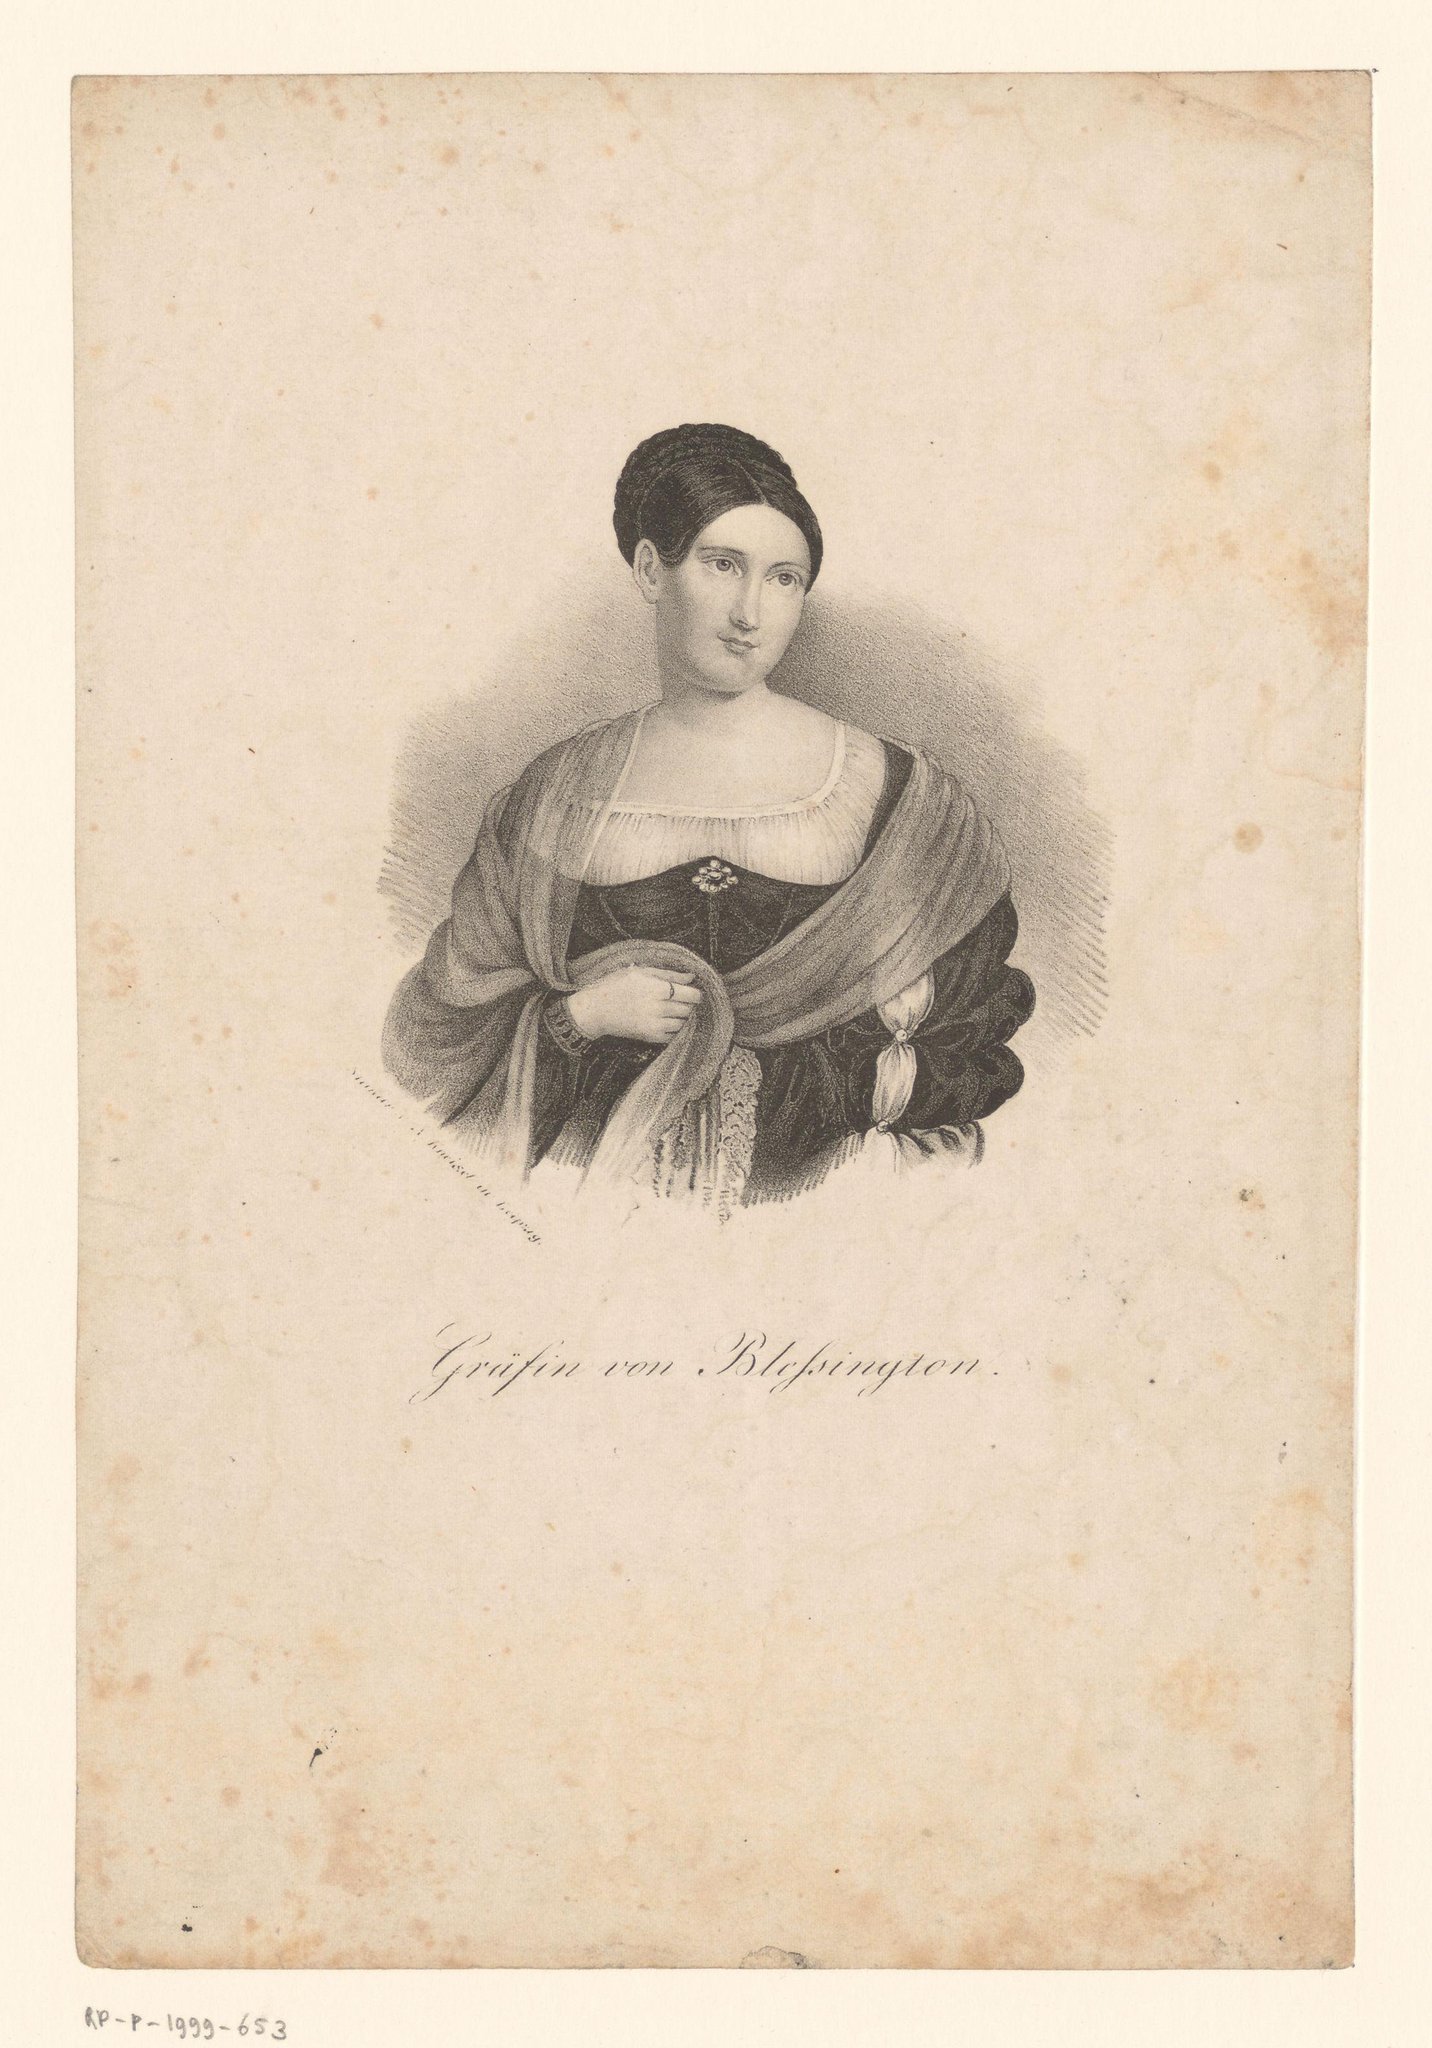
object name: print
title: Grafin von Blessington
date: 1820-1900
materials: paper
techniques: lithograph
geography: leipzig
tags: historical persons, portrait of a writer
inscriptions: collector's mark: Lugt 2760, collector's mark: Lugt 2228